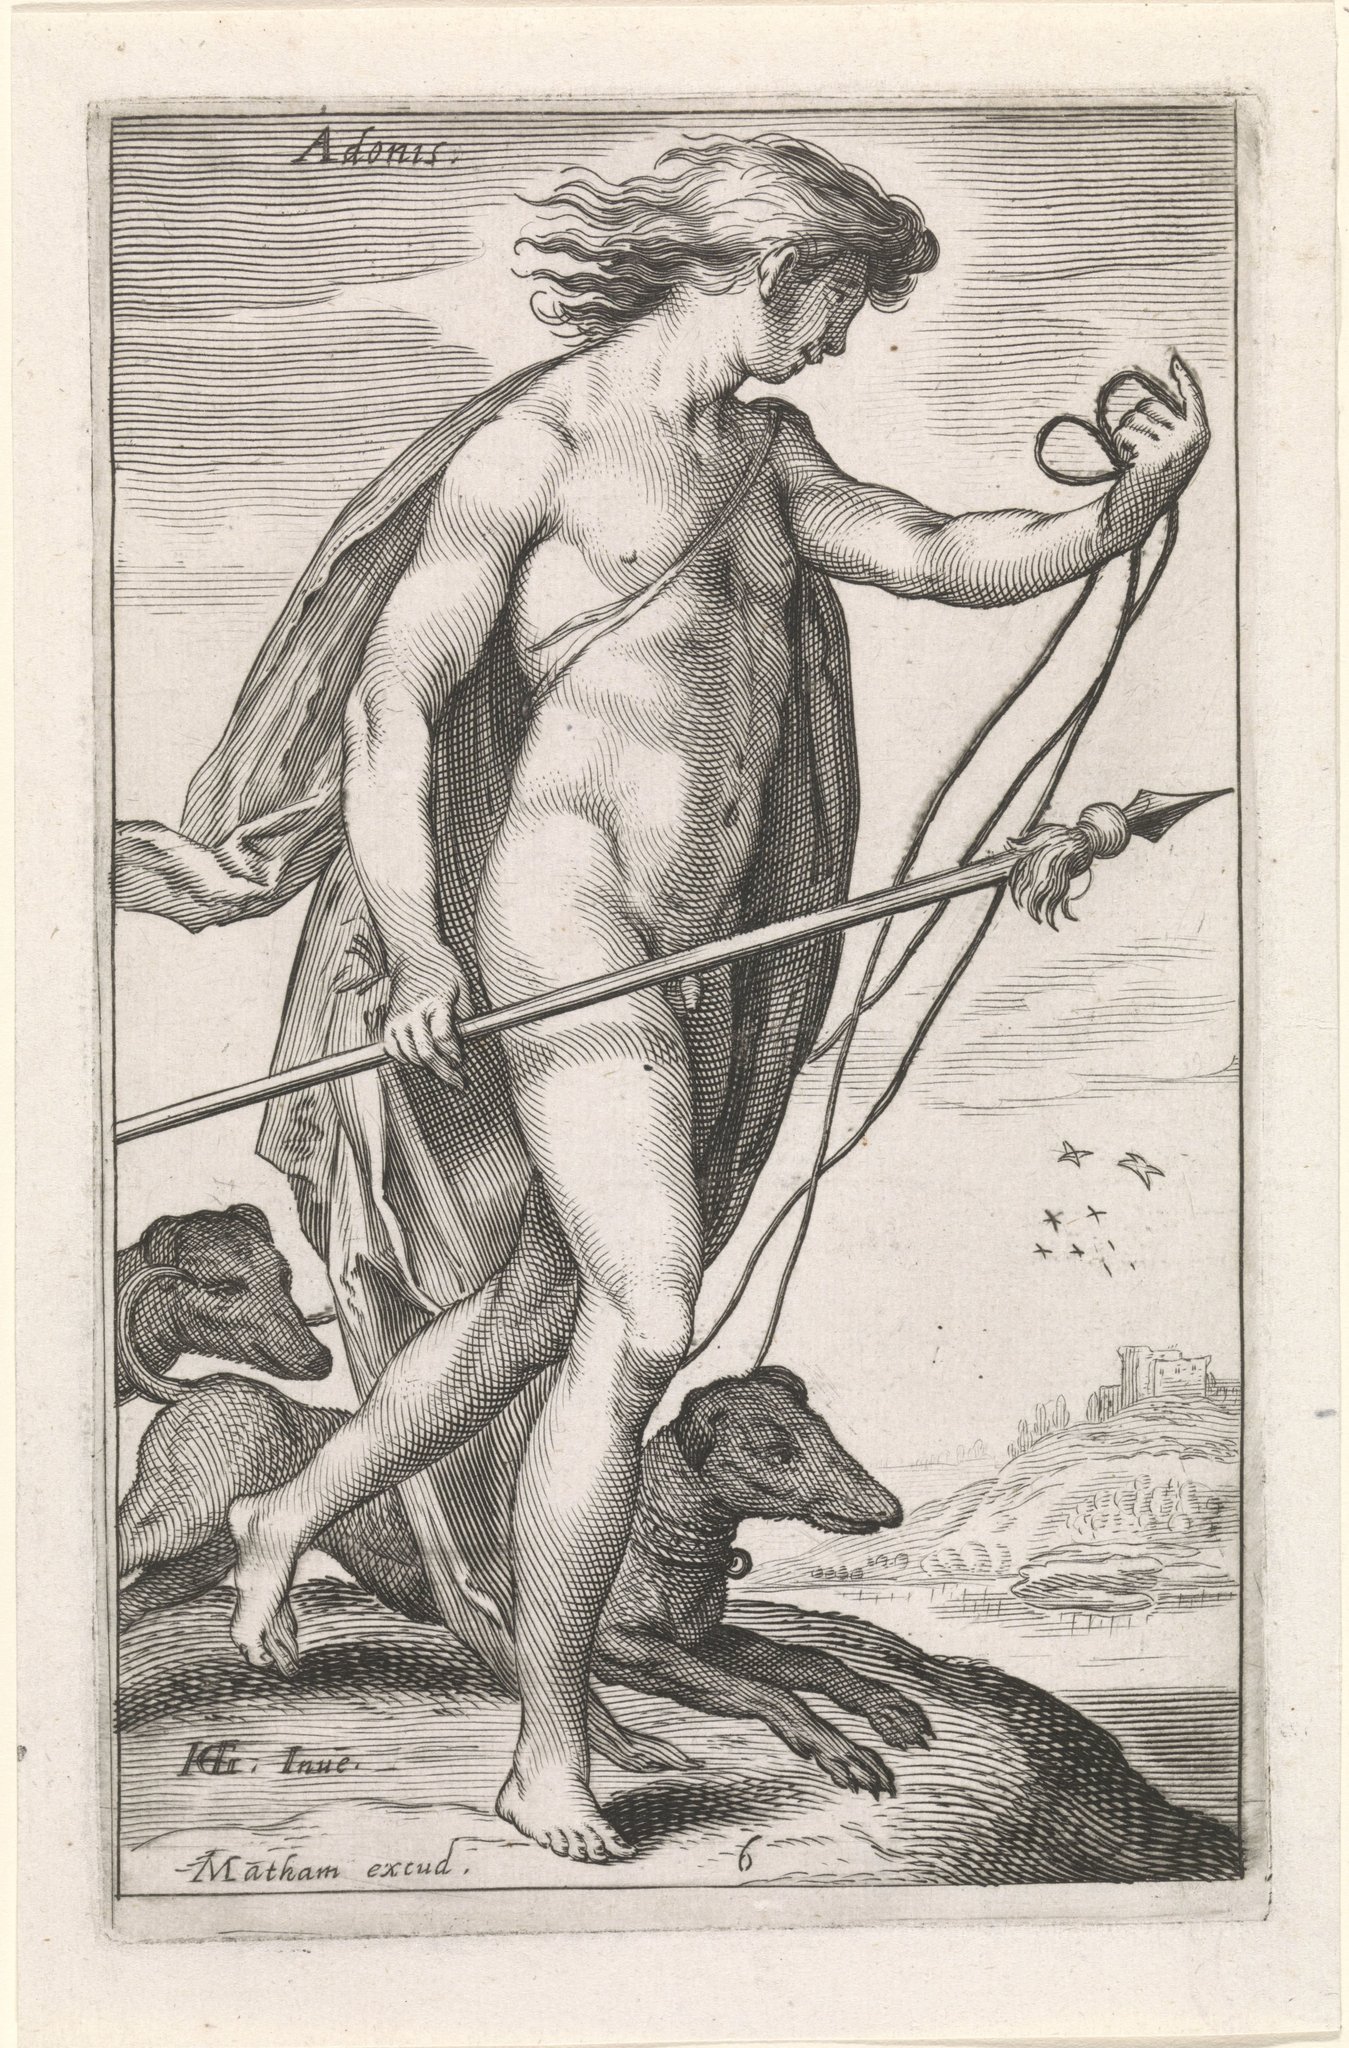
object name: print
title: Mythologische figuren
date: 1581-1631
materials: paper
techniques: engraving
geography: haarlem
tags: hunting dogs, casting weapons: spear, adonis hunting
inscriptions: collector's mark: Lugt 240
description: Adonis met speer en jachthonden in een landschap.